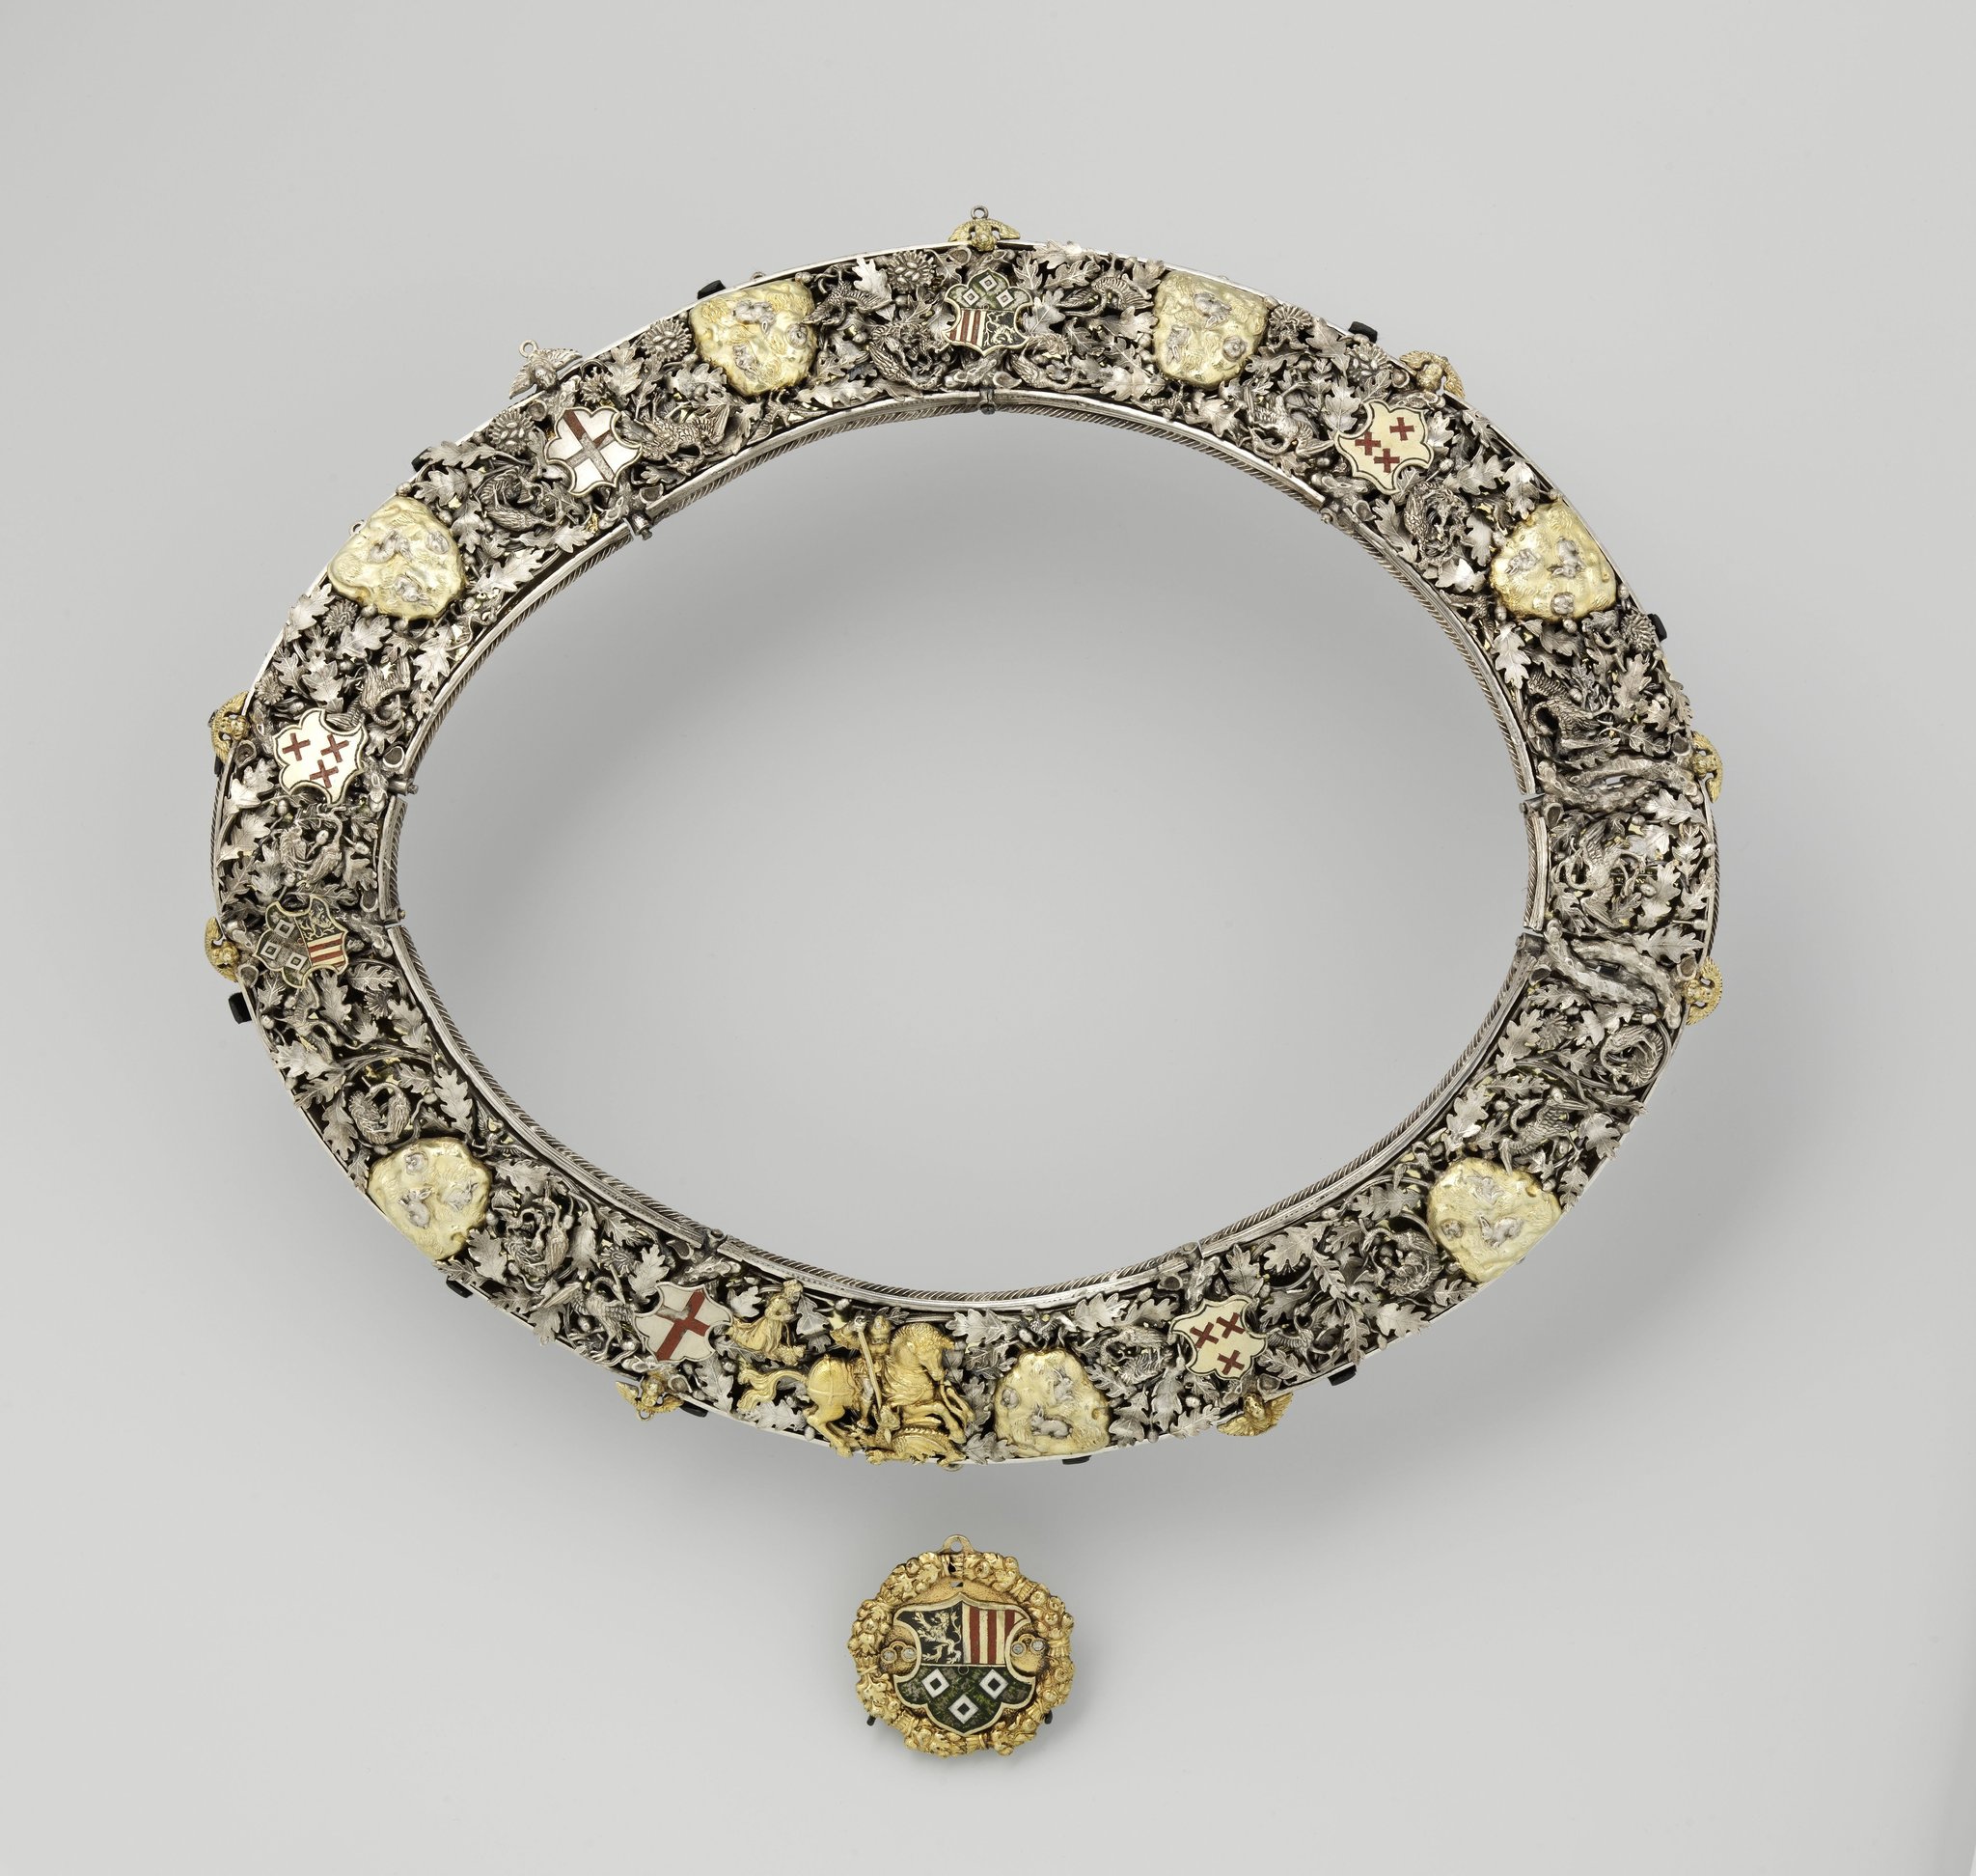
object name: schuttersketen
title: Ceremonial Chain of the Guild of Saint George of Zevenbergen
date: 1520-1541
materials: silver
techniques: gilding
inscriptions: inscription: ‘Heer Cornelis van Bergen, heer van Zevenbergen, Coninck anno 1546, die 18 julii’, town mark: ‘stadskeur Breda of Bergen op Zoom’ three St Andrew's crosses in a shield, inscription: ‘deese RinKraag schoon gemaakt door Cs Dijkens te 7 bergen 1822’, maker's mark: ‘O’ with a bow above in a shield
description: All of the visible elements on the chain have a special meaning. The patron saint, Saint George, and his arms signify that the collar belonged to the Guild of Saint George, while the other devices indicate the authority to which it answered. Even the seven mountains, after which the town of Zevenbergen is named, are depicted. The oak leaves stand for religious steadfastness, the storks for piety, and respect for church, state, and master.